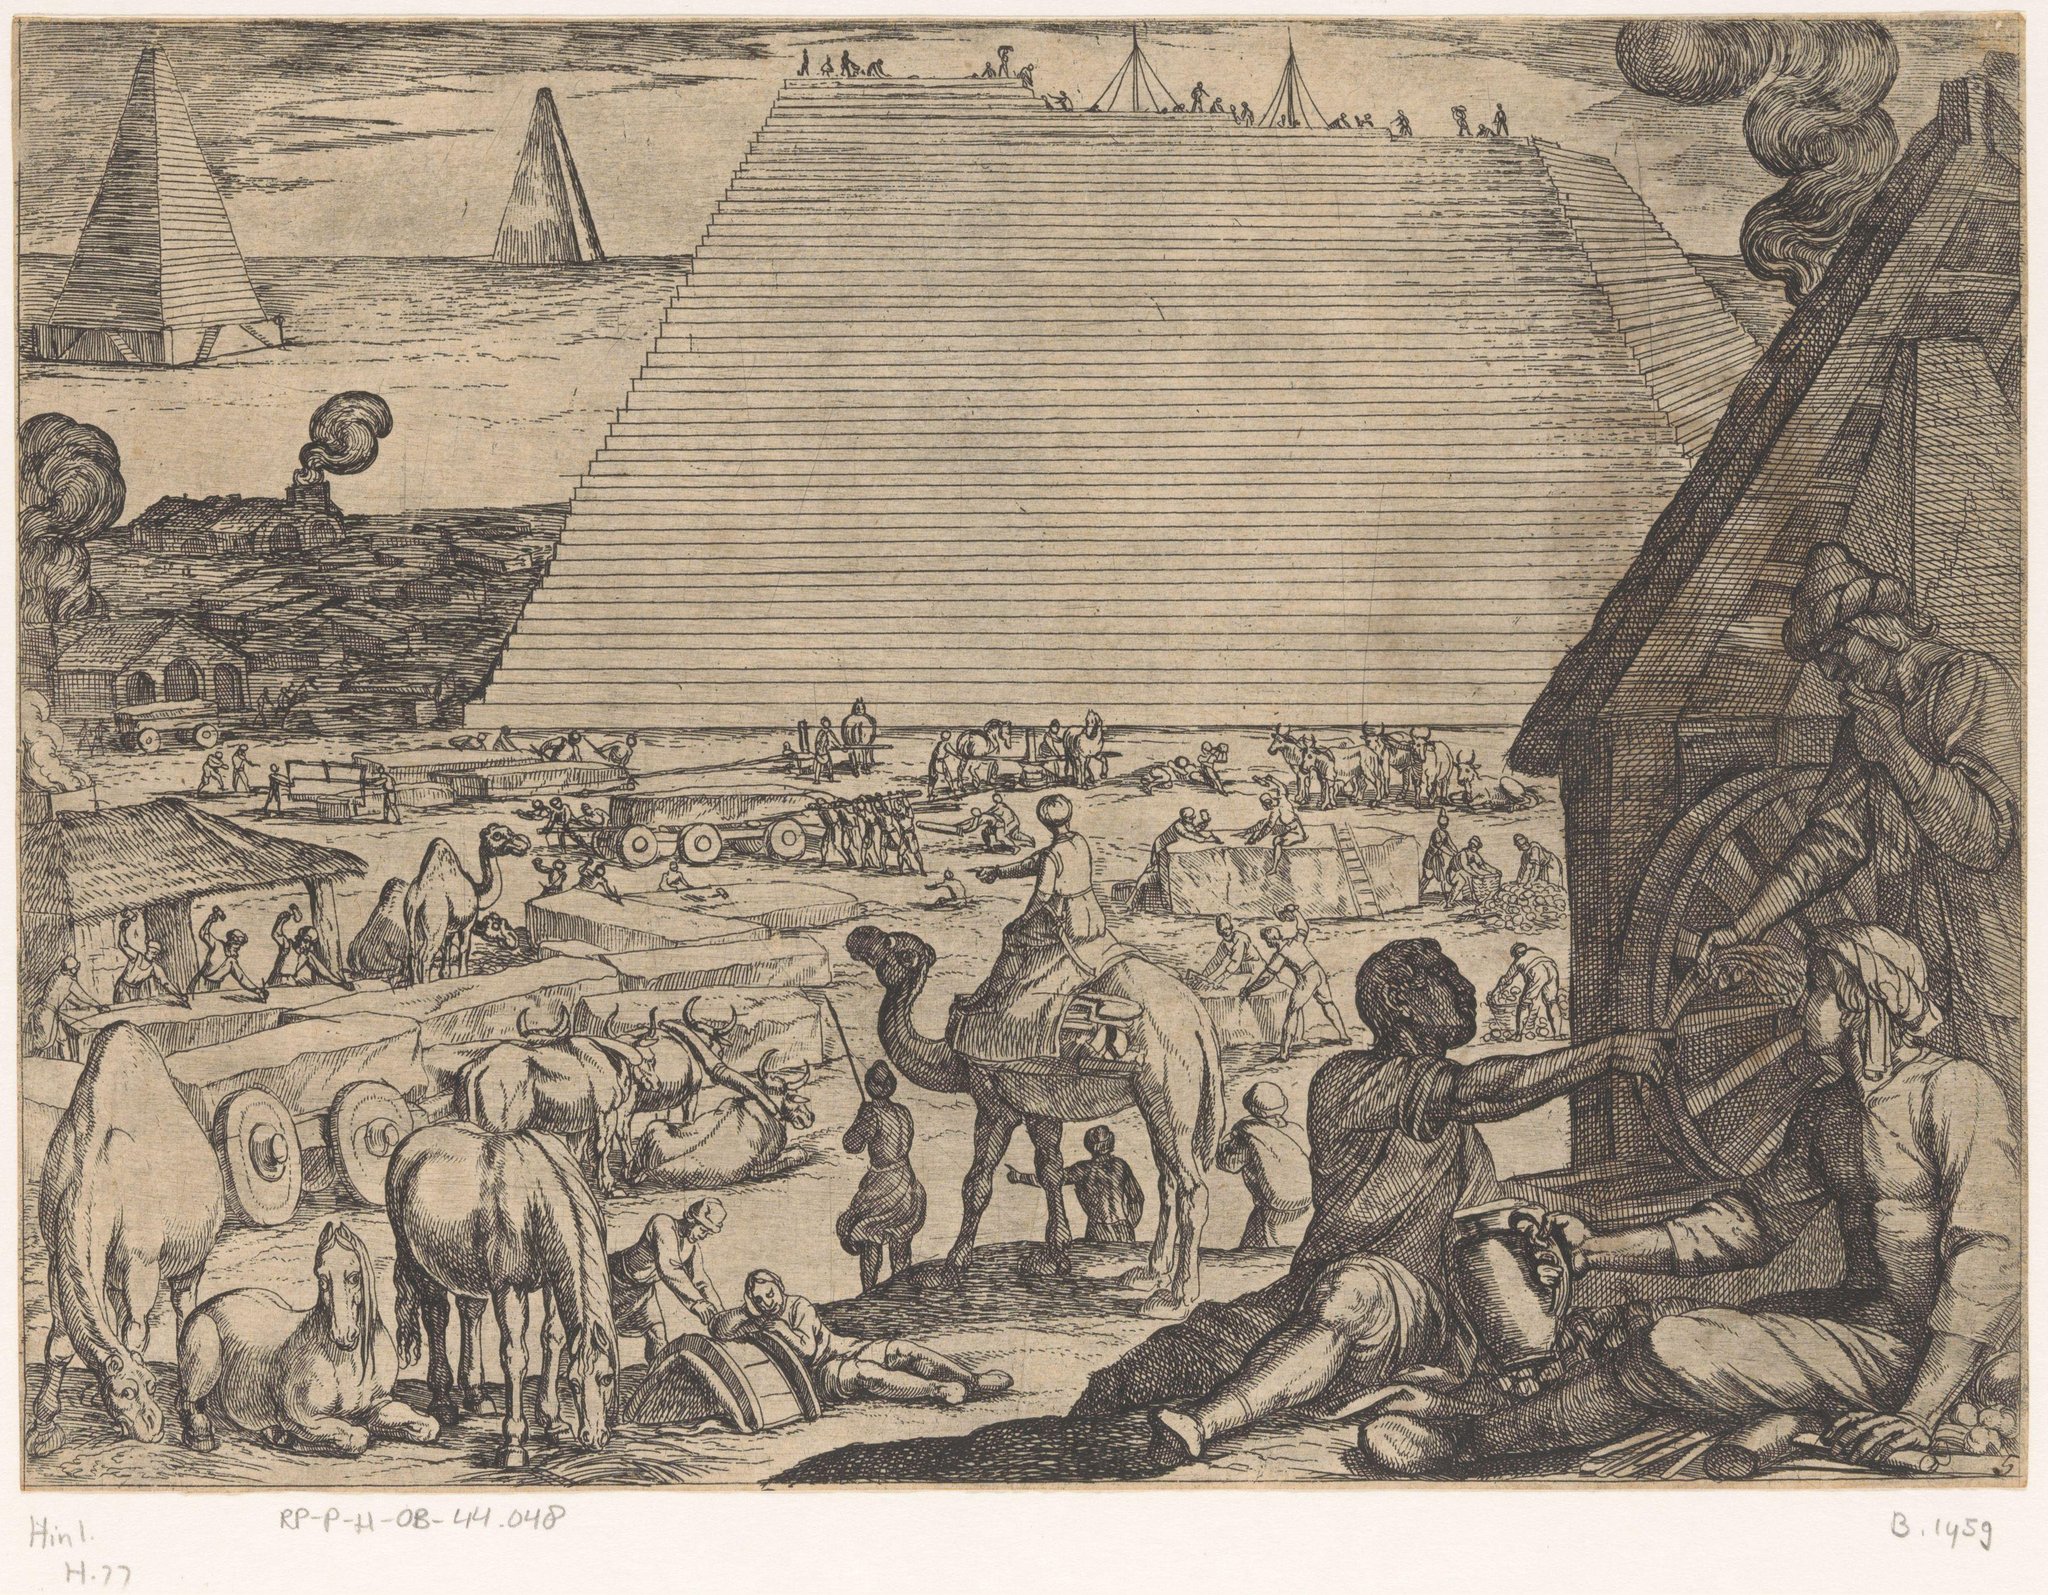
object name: print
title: Septem orbis admiranda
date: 1608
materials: paper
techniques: etching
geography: antwerp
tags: egyptian pyramids (wonder of the world), the seven wonders of the world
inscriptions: collector's mark: Lugt 11, collector's mark: ‘Hinloopen’, number: ‘5’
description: Deze prent maakt deel uit van een reeks van zeven prenten (+ titelprent) van de zeven wereldwonderen.